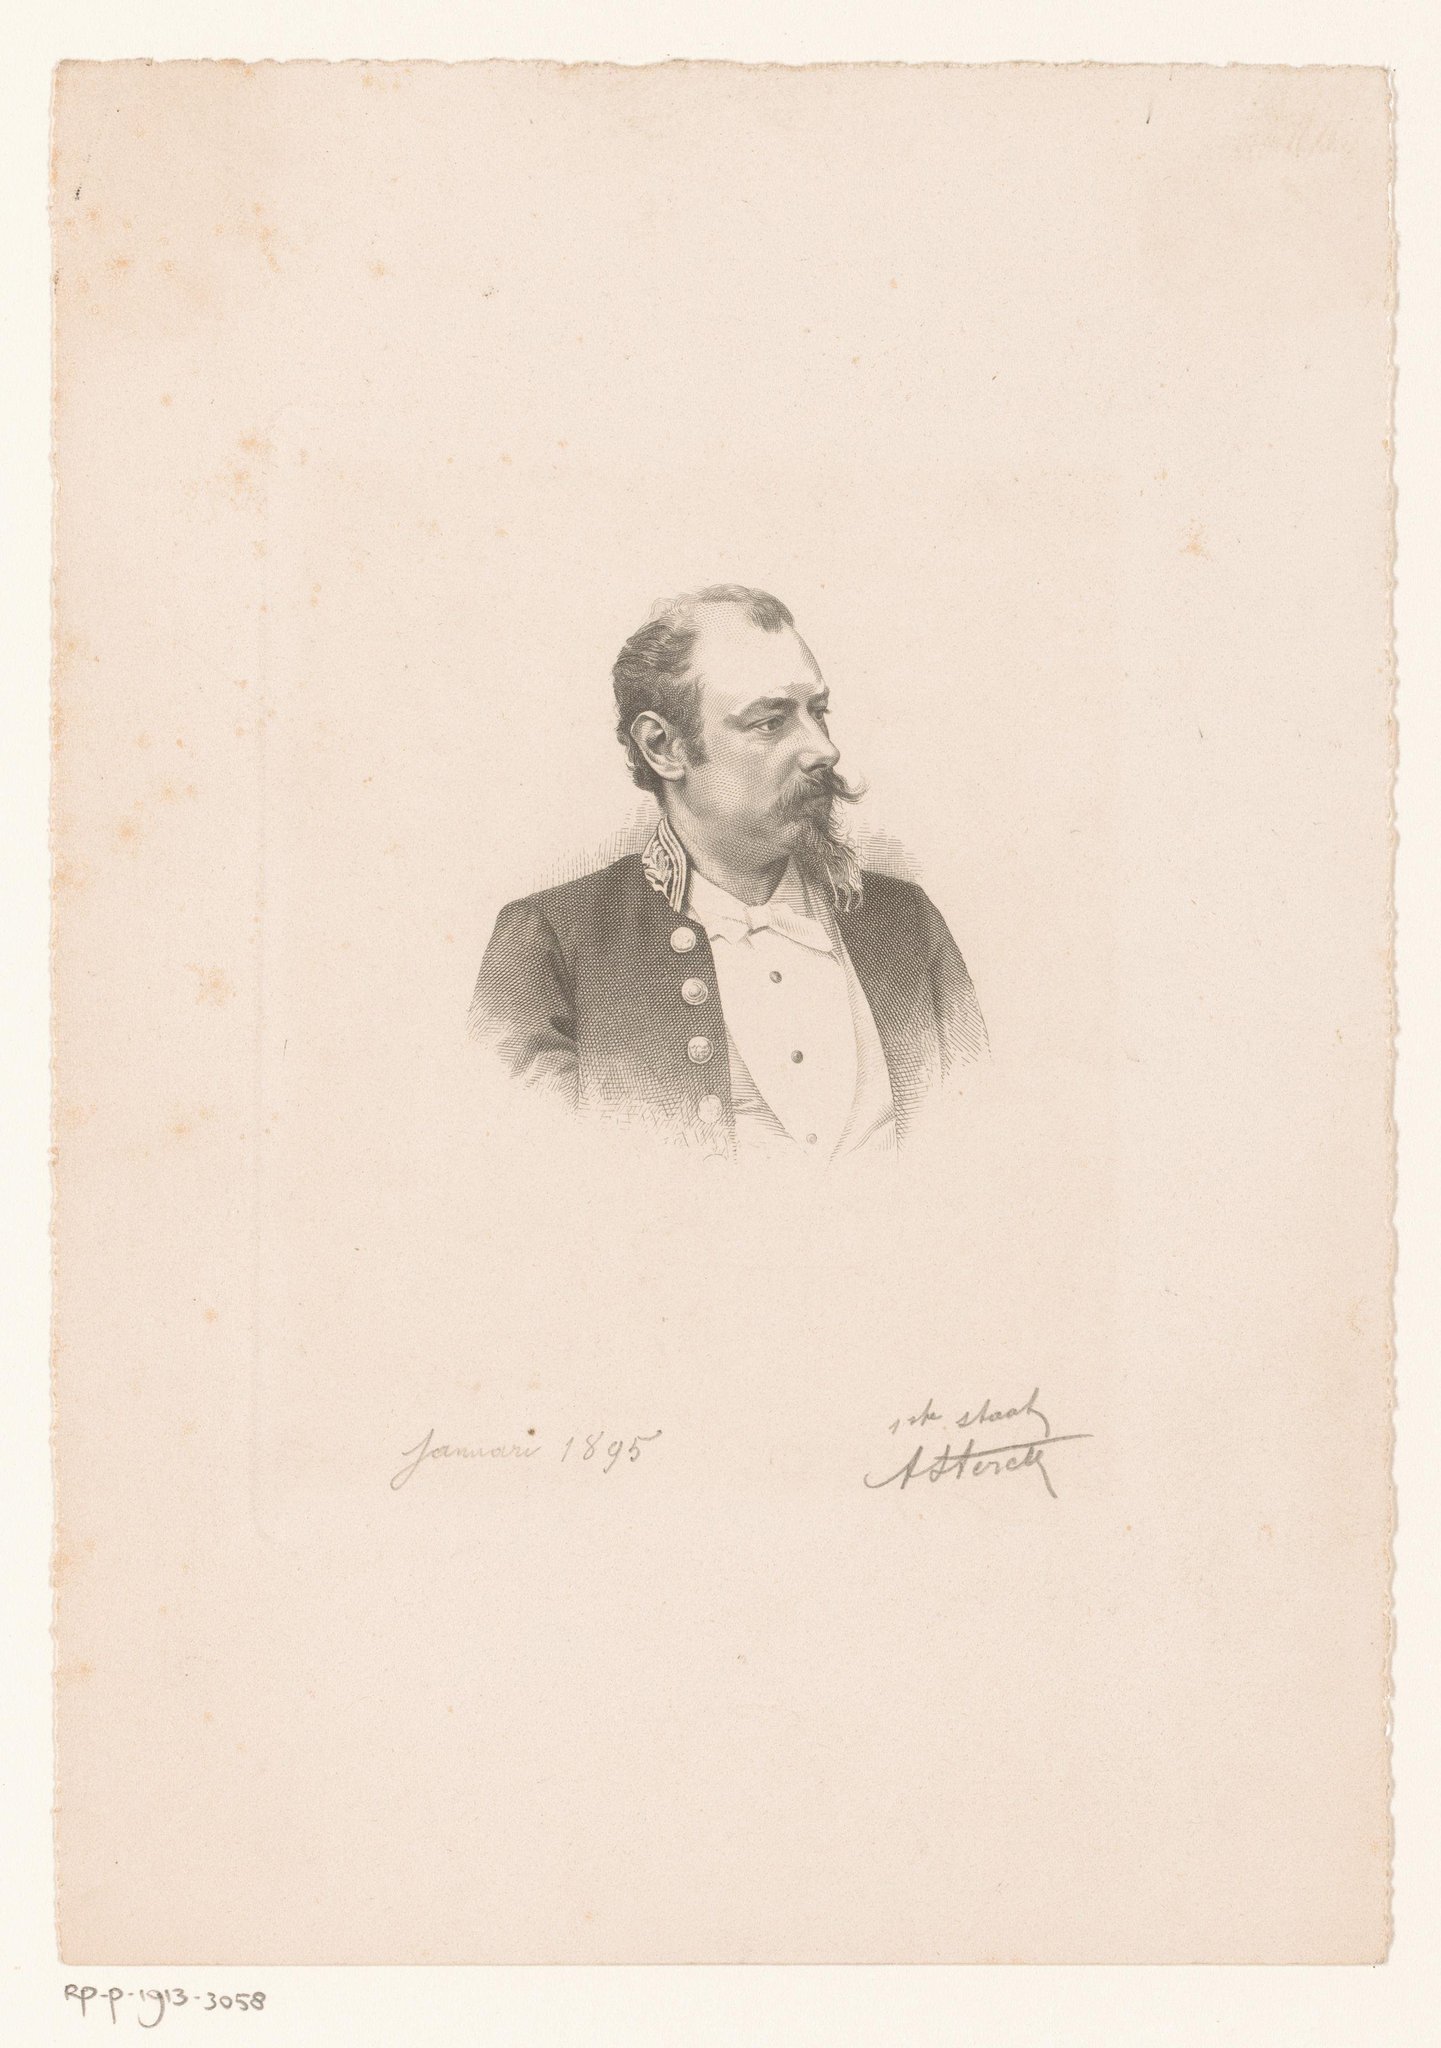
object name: print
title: Portret van Jan van Rijswijck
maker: arthur sterck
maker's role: print maker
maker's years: 1868-1897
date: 1801-1895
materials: paper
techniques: etching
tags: politician, historical persons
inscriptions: collector's mark: Lugt 2228, annotation: ‘1ste staat’